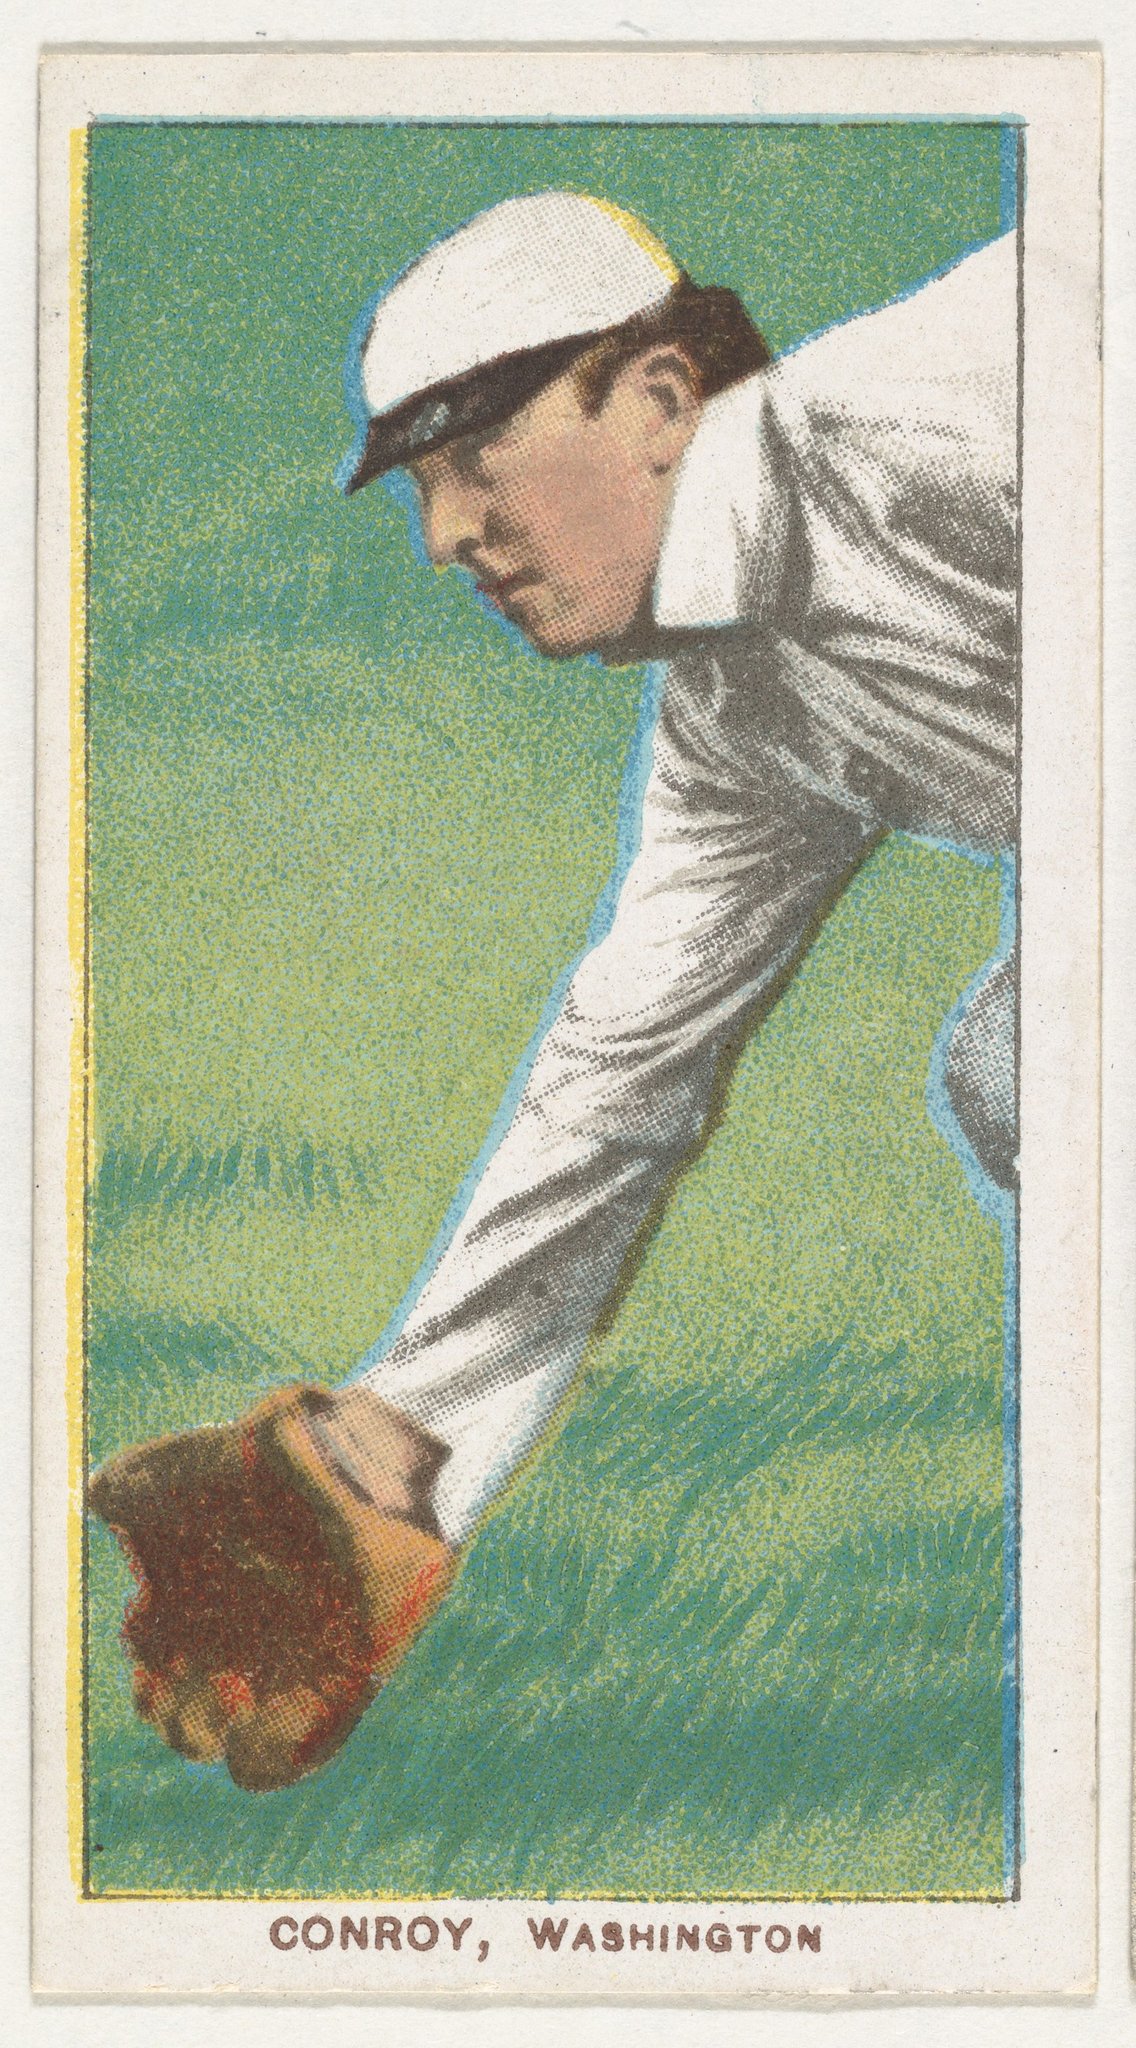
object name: baseball card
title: Conroy, Washington, American League, from the White Border series (T206) for the American Tobacco Company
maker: american tobacco company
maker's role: publisher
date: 1909-1911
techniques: lithography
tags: men,baseball,athletes